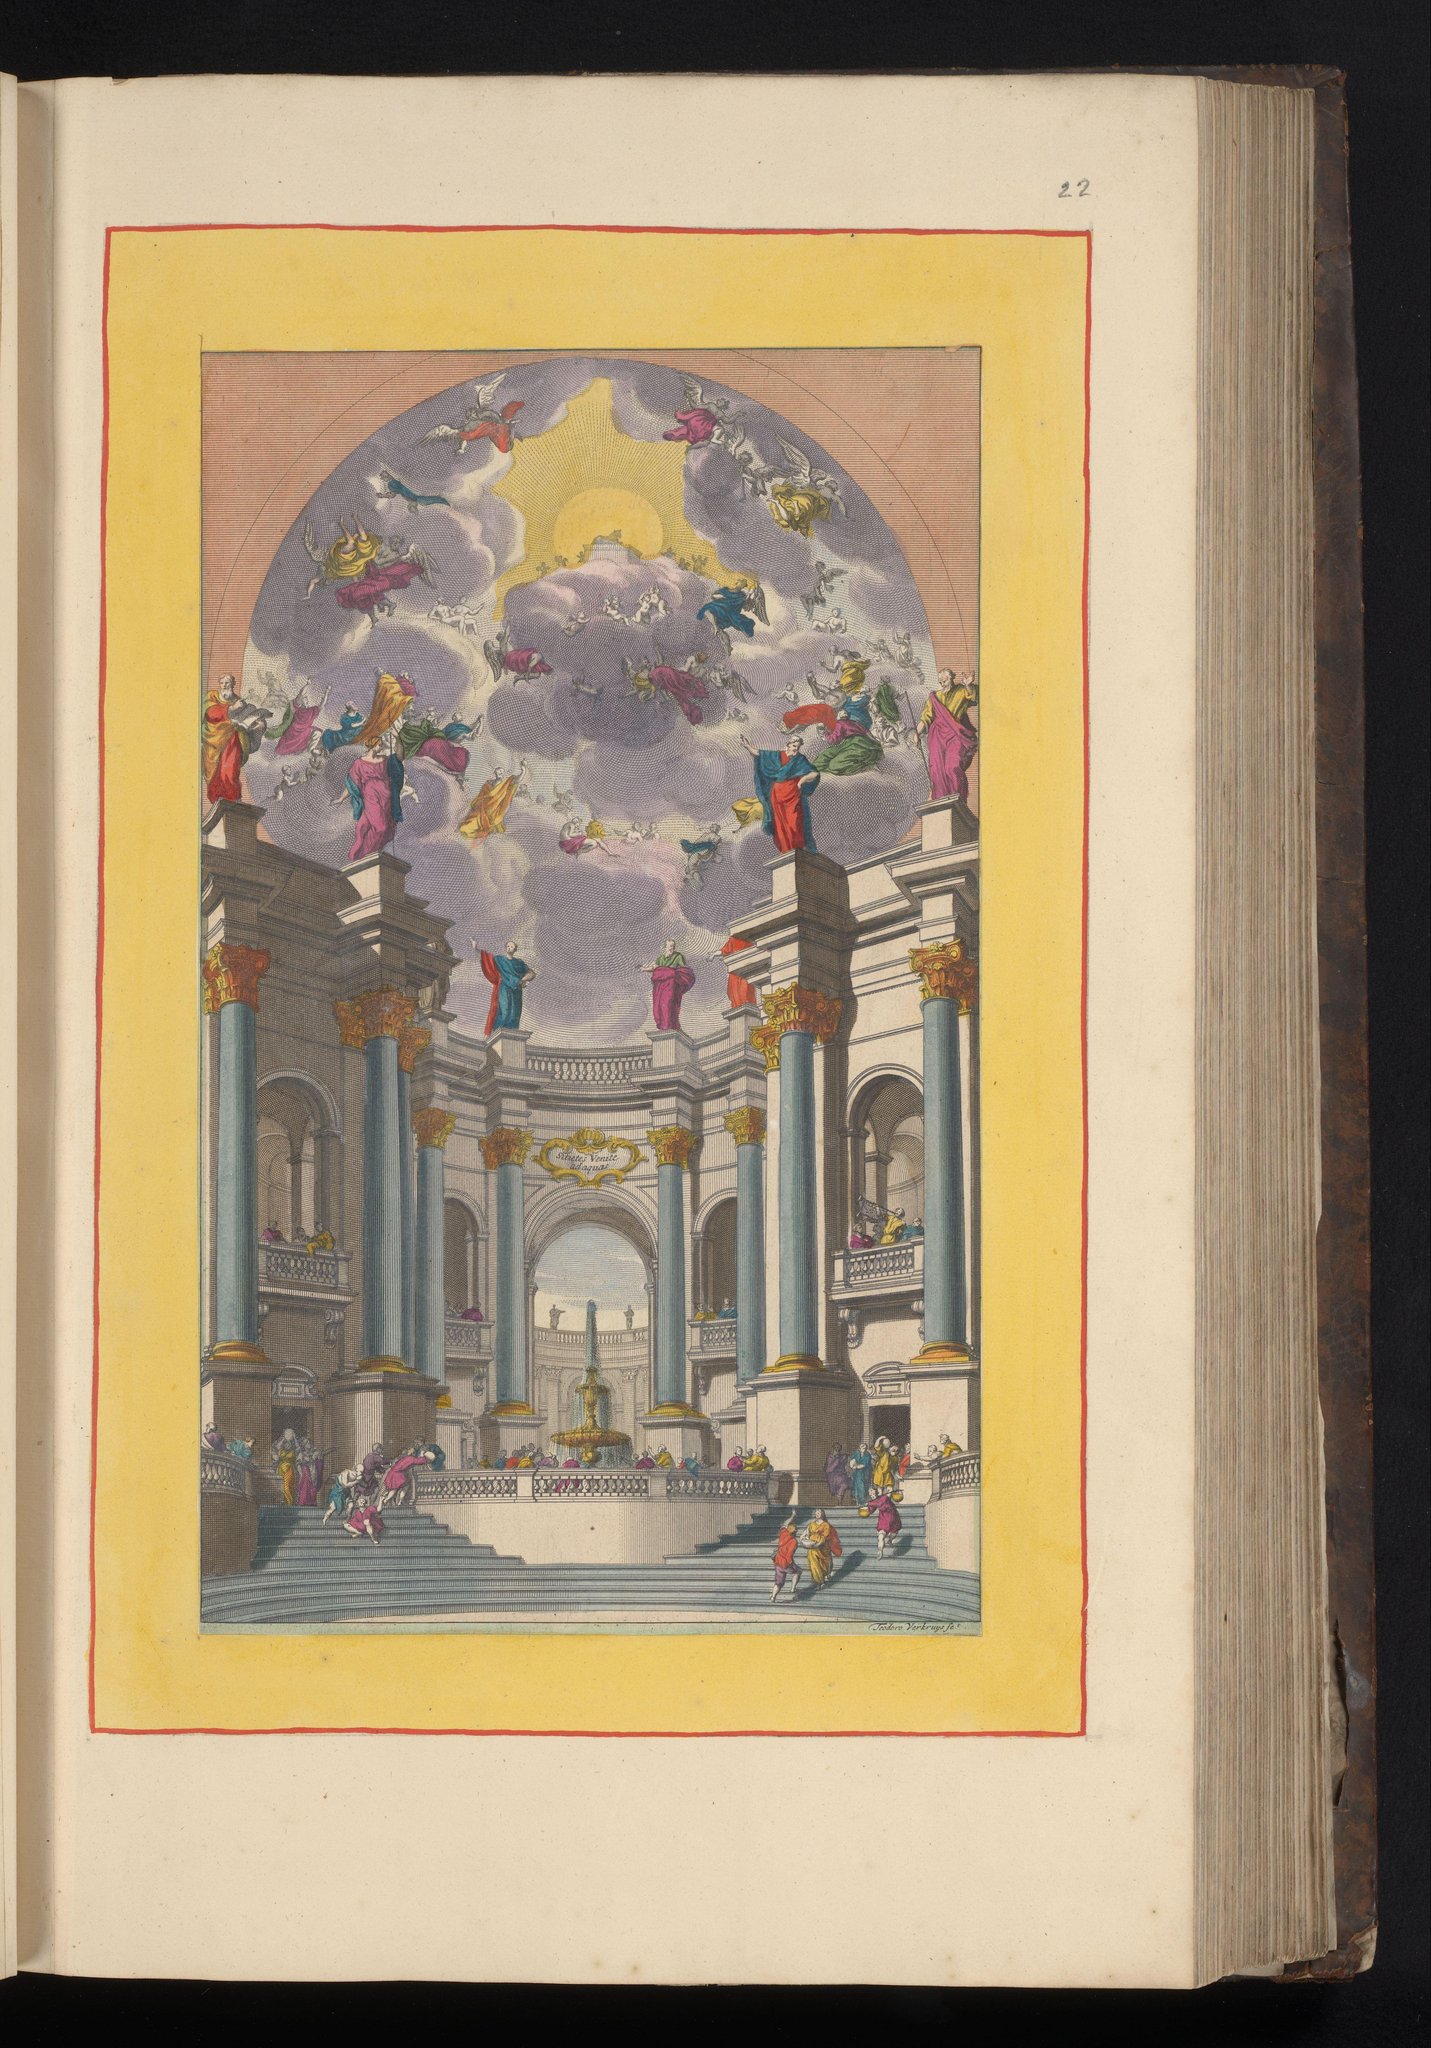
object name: print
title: Sitietes venite ad aquas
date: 1656-1739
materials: paper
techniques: colour, etching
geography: the hague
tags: ornamental fountain, fantastic architecture, unrealistic architectural fantasies, angels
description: Gezicht op een fantasiearchitectuur met een fontein. Mensen verzamelen zich rond de fontein. Boven zweven engelen in de lucht. Prent maakt deel uit van een album.